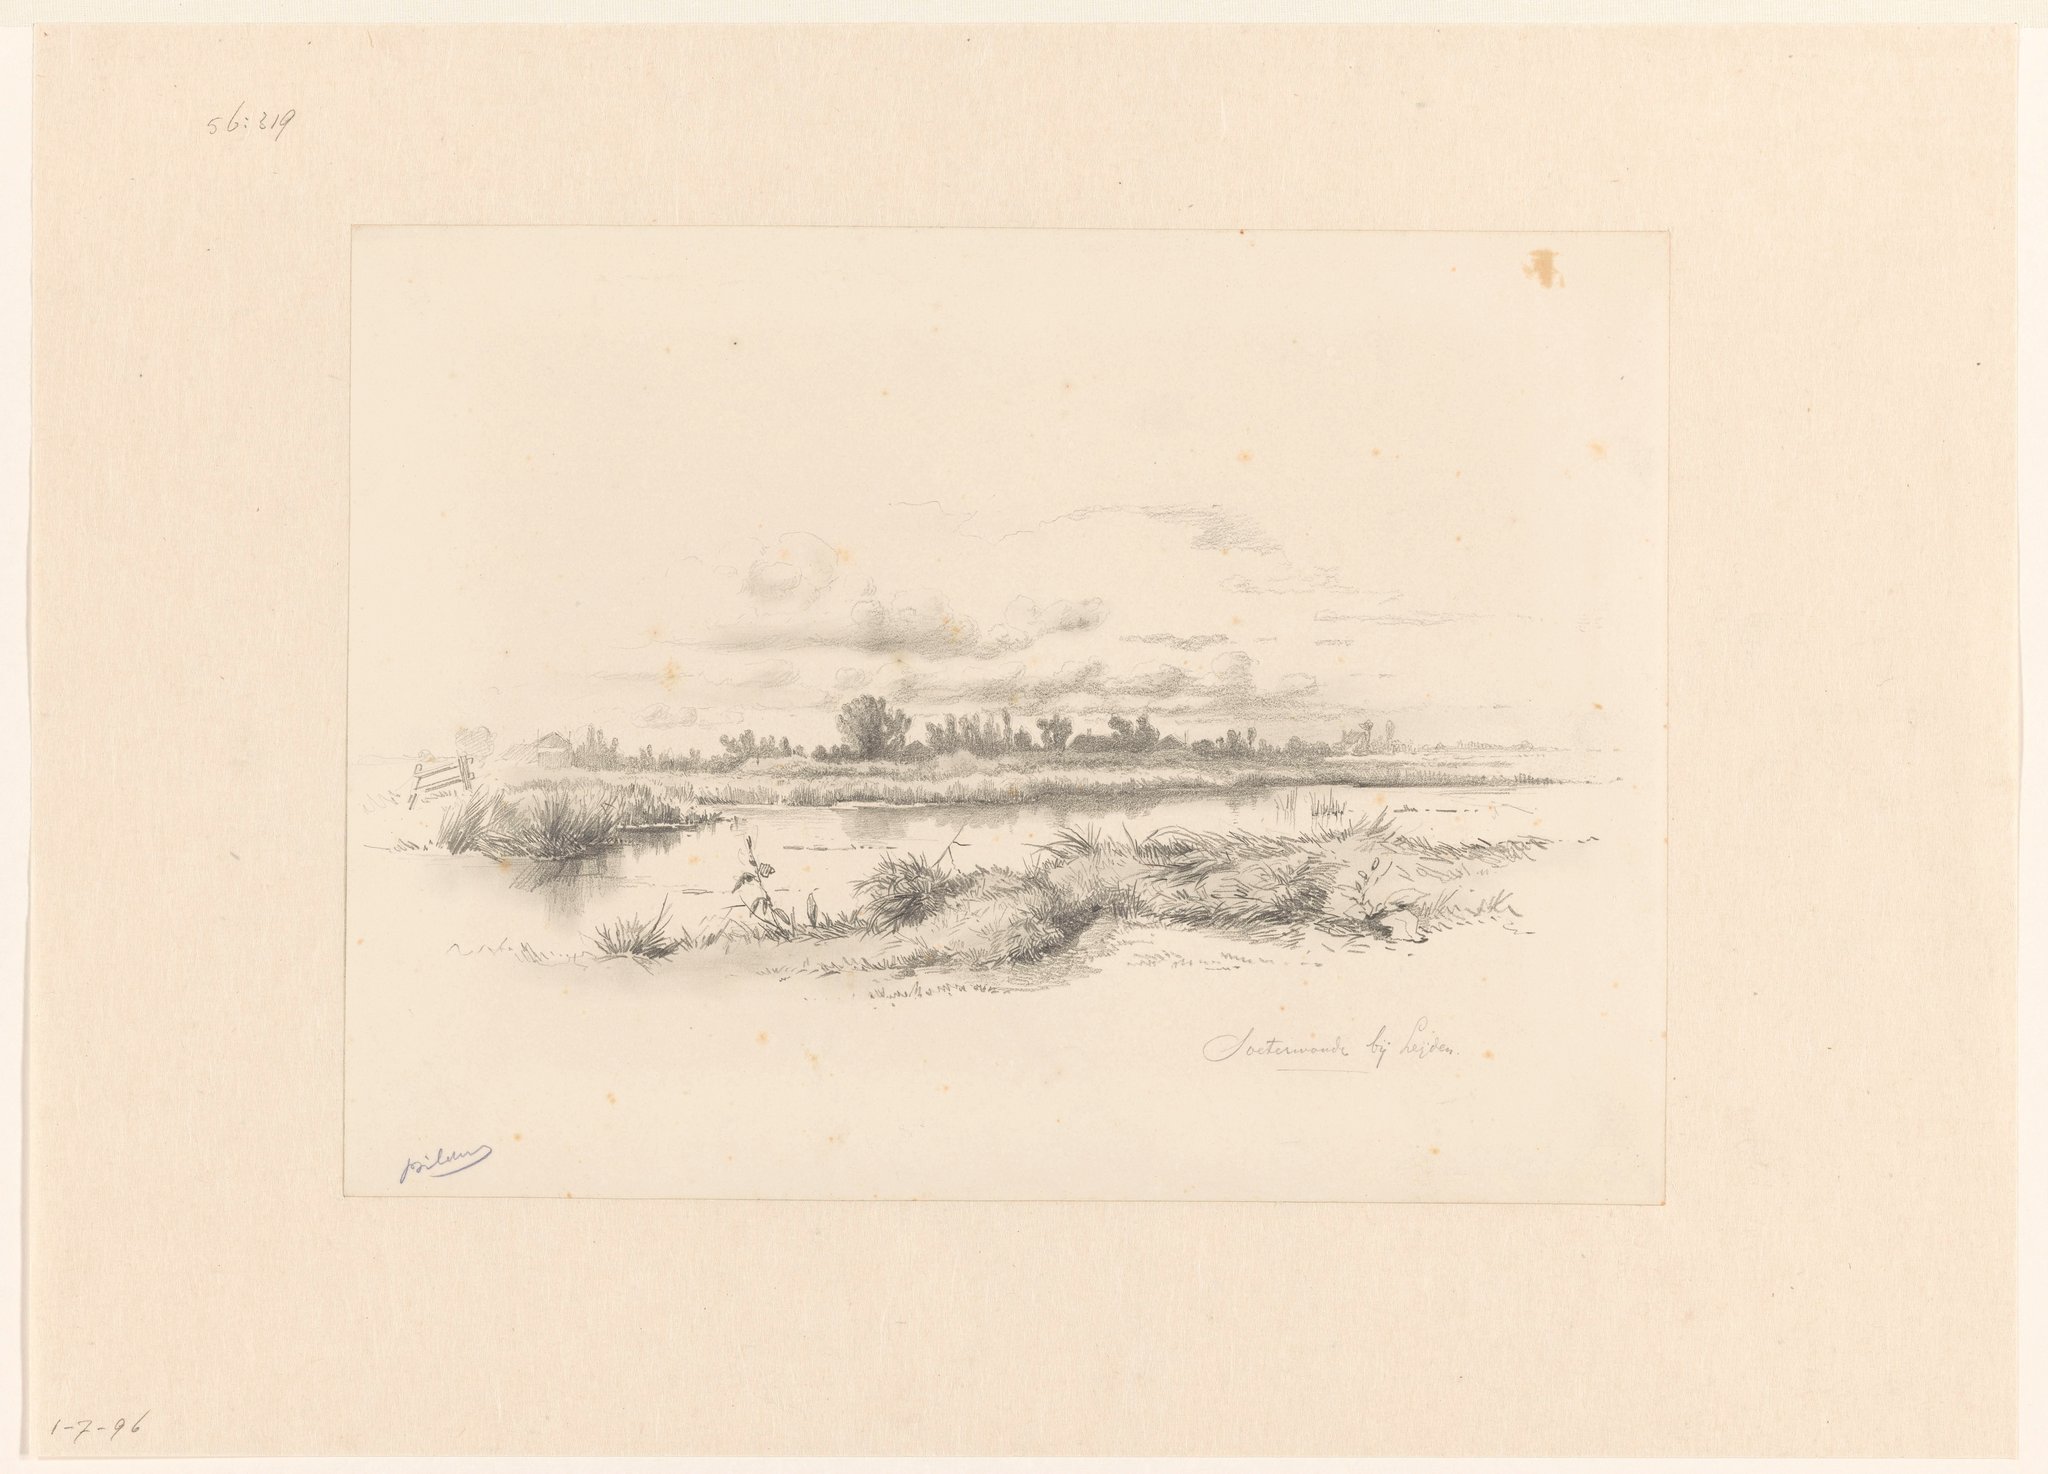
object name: drawing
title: Gezicht over het water bij Zoeterwoude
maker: gerard bilders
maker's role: draughtsman, print maker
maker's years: 1838-1865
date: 1848-1865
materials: paper, pencil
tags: landscapes in the temperate zone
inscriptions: inscription: ‘Soeterwoude bij Leijden [?]’